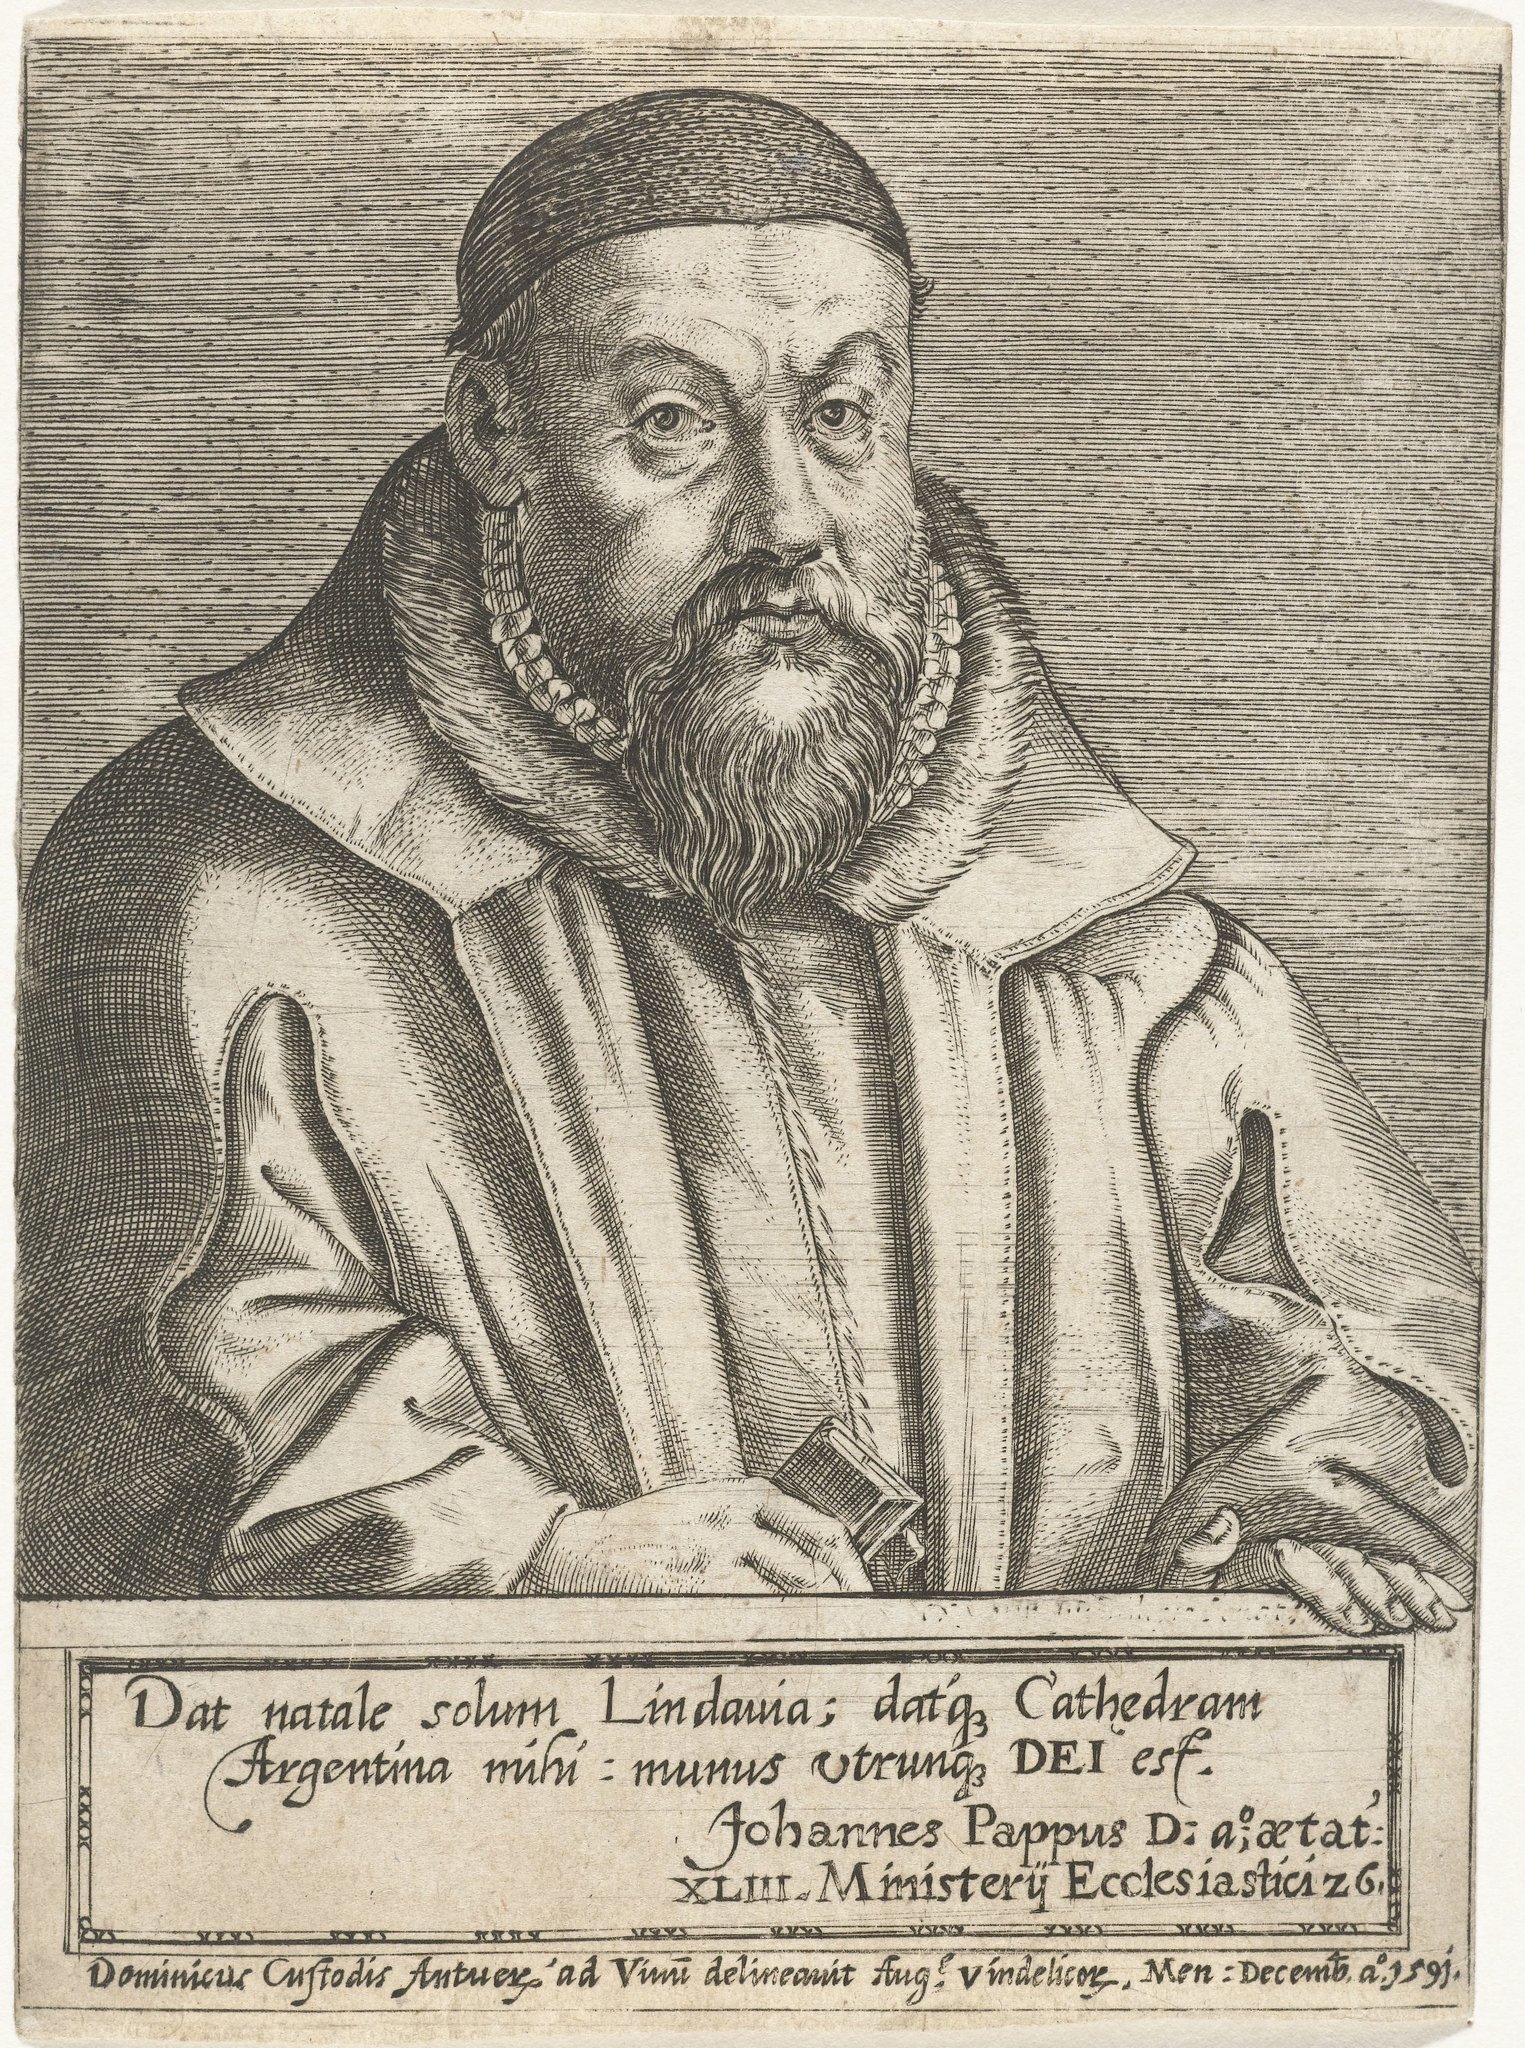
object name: print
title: Portret van de theoloog Johannes Pappus op 43-jarige leeftijd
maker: dominicus custos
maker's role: print maker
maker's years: 1560-1615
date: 1591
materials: paper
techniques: engraving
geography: augsburg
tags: lindau im bodensee, straatsburg (frankrijk), theoloog, johannes pappus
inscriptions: collector's mark: Lugt 2228